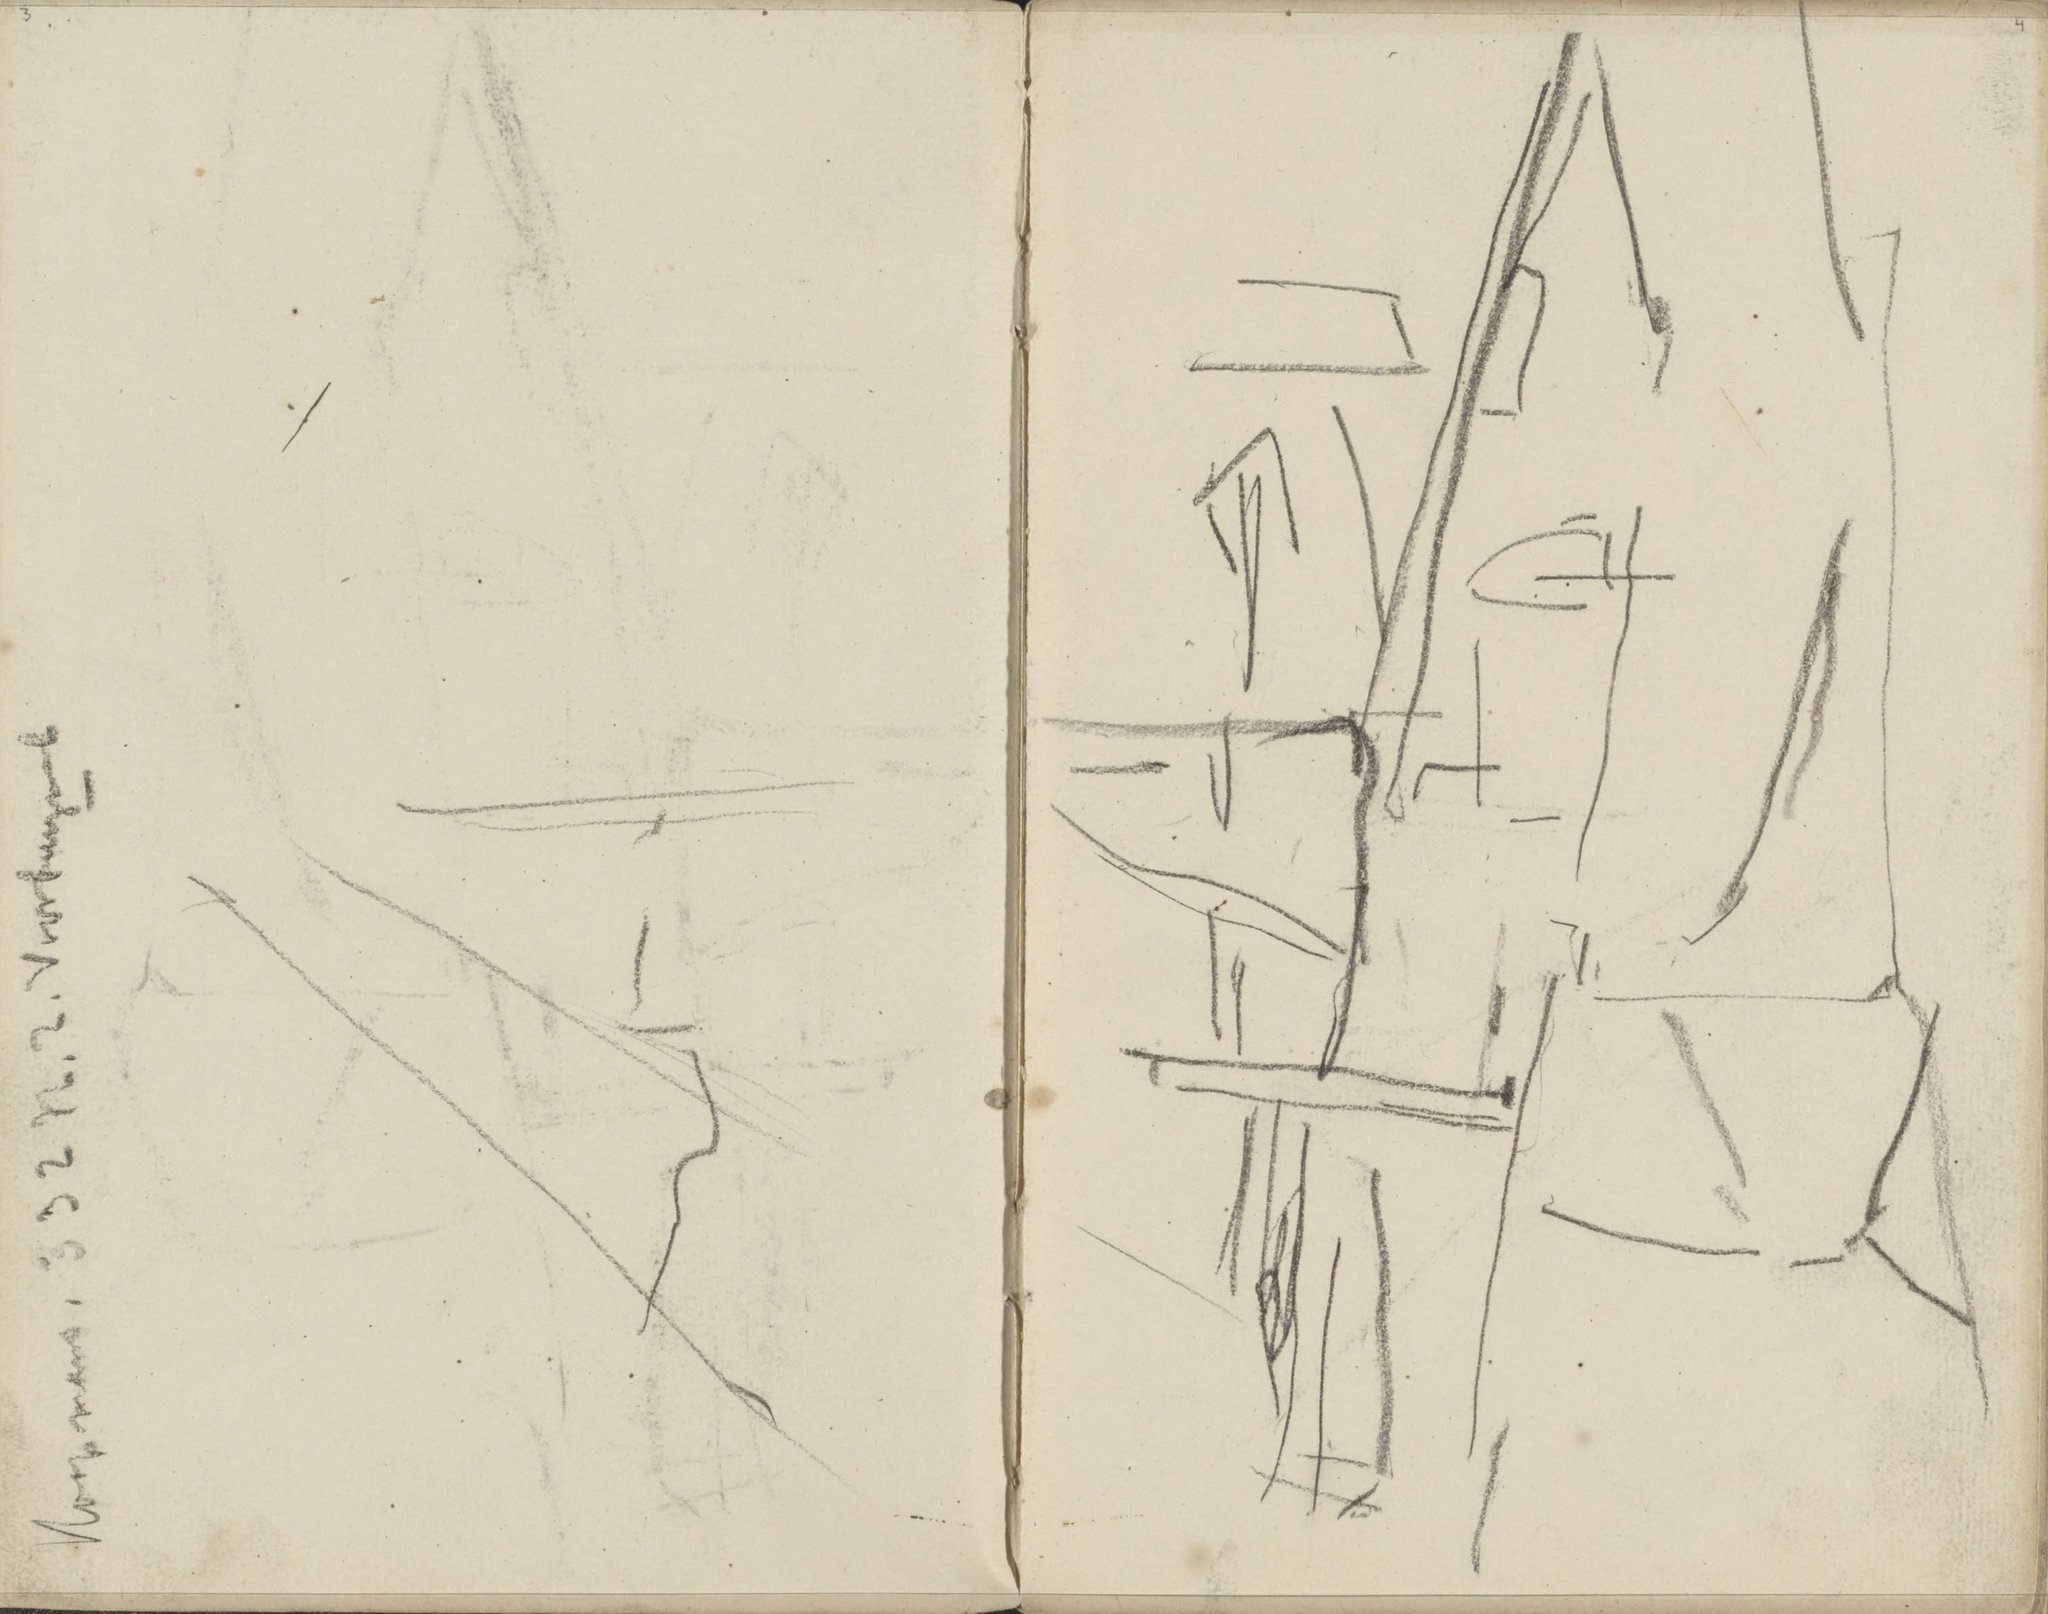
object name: sketchbook leaf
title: Boten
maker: george hendrik breitner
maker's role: draughtsman, painter, print maker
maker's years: 1857-1923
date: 1887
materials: chalk, paper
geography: amsterdam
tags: ships (in general)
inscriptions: annotation: ‘Koopmans, 332 N.Z. Voorburgwal’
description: Pagina 3 en pagina 4 uit een schetsboek met 12 bladen.